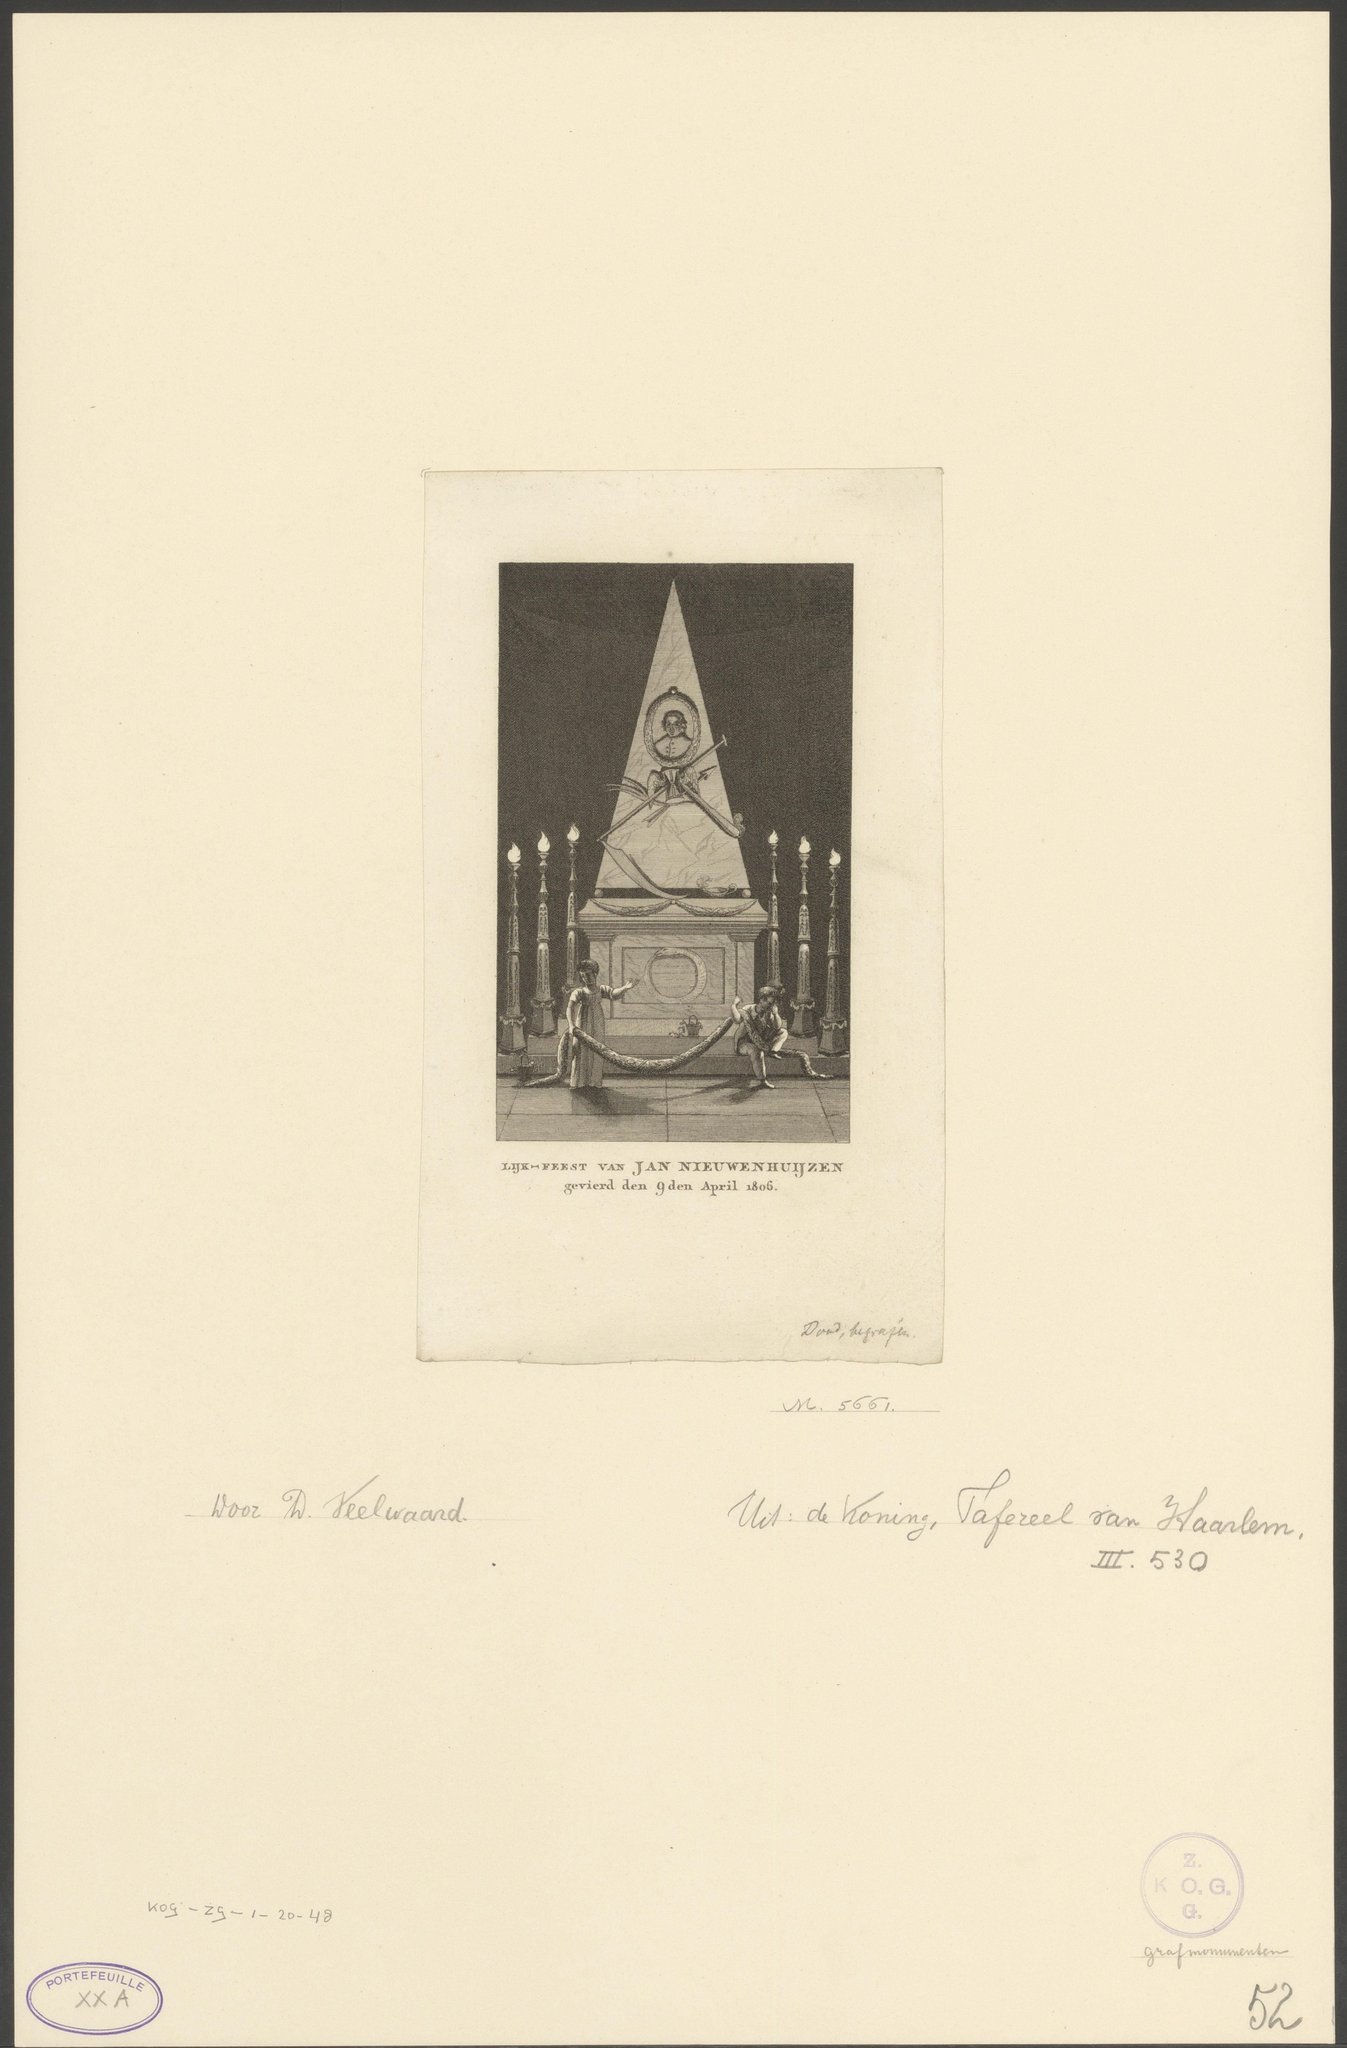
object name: print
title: Lijk-feest van Jan Nieuwenhuijzen gevierd den 9den April 1806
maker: Anonymous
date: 1808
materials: paper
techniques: etching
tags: haarlem, amsterdam, jan nieuwenhuyzen, grave-building, monumental tomb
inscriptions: collector's mark: Lugt 1641, stamp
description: Allegorisch grafmonument voor de op 24 februari 1806 overleden Jan Nieuwenhuyzen, oprichter van de Maatschappij tot Nut van 't Algemeen. Tombe met piramide met zes brandende olielampen. Voor het monument twee kinderen met een guirlande. Onderwerpsrubrieken binnen de Atlas Zeden en Gewoonten: Zeden en Gewoonten in Engeren Zin, Des menschen beging, midden en einde, Grafmonumenten.